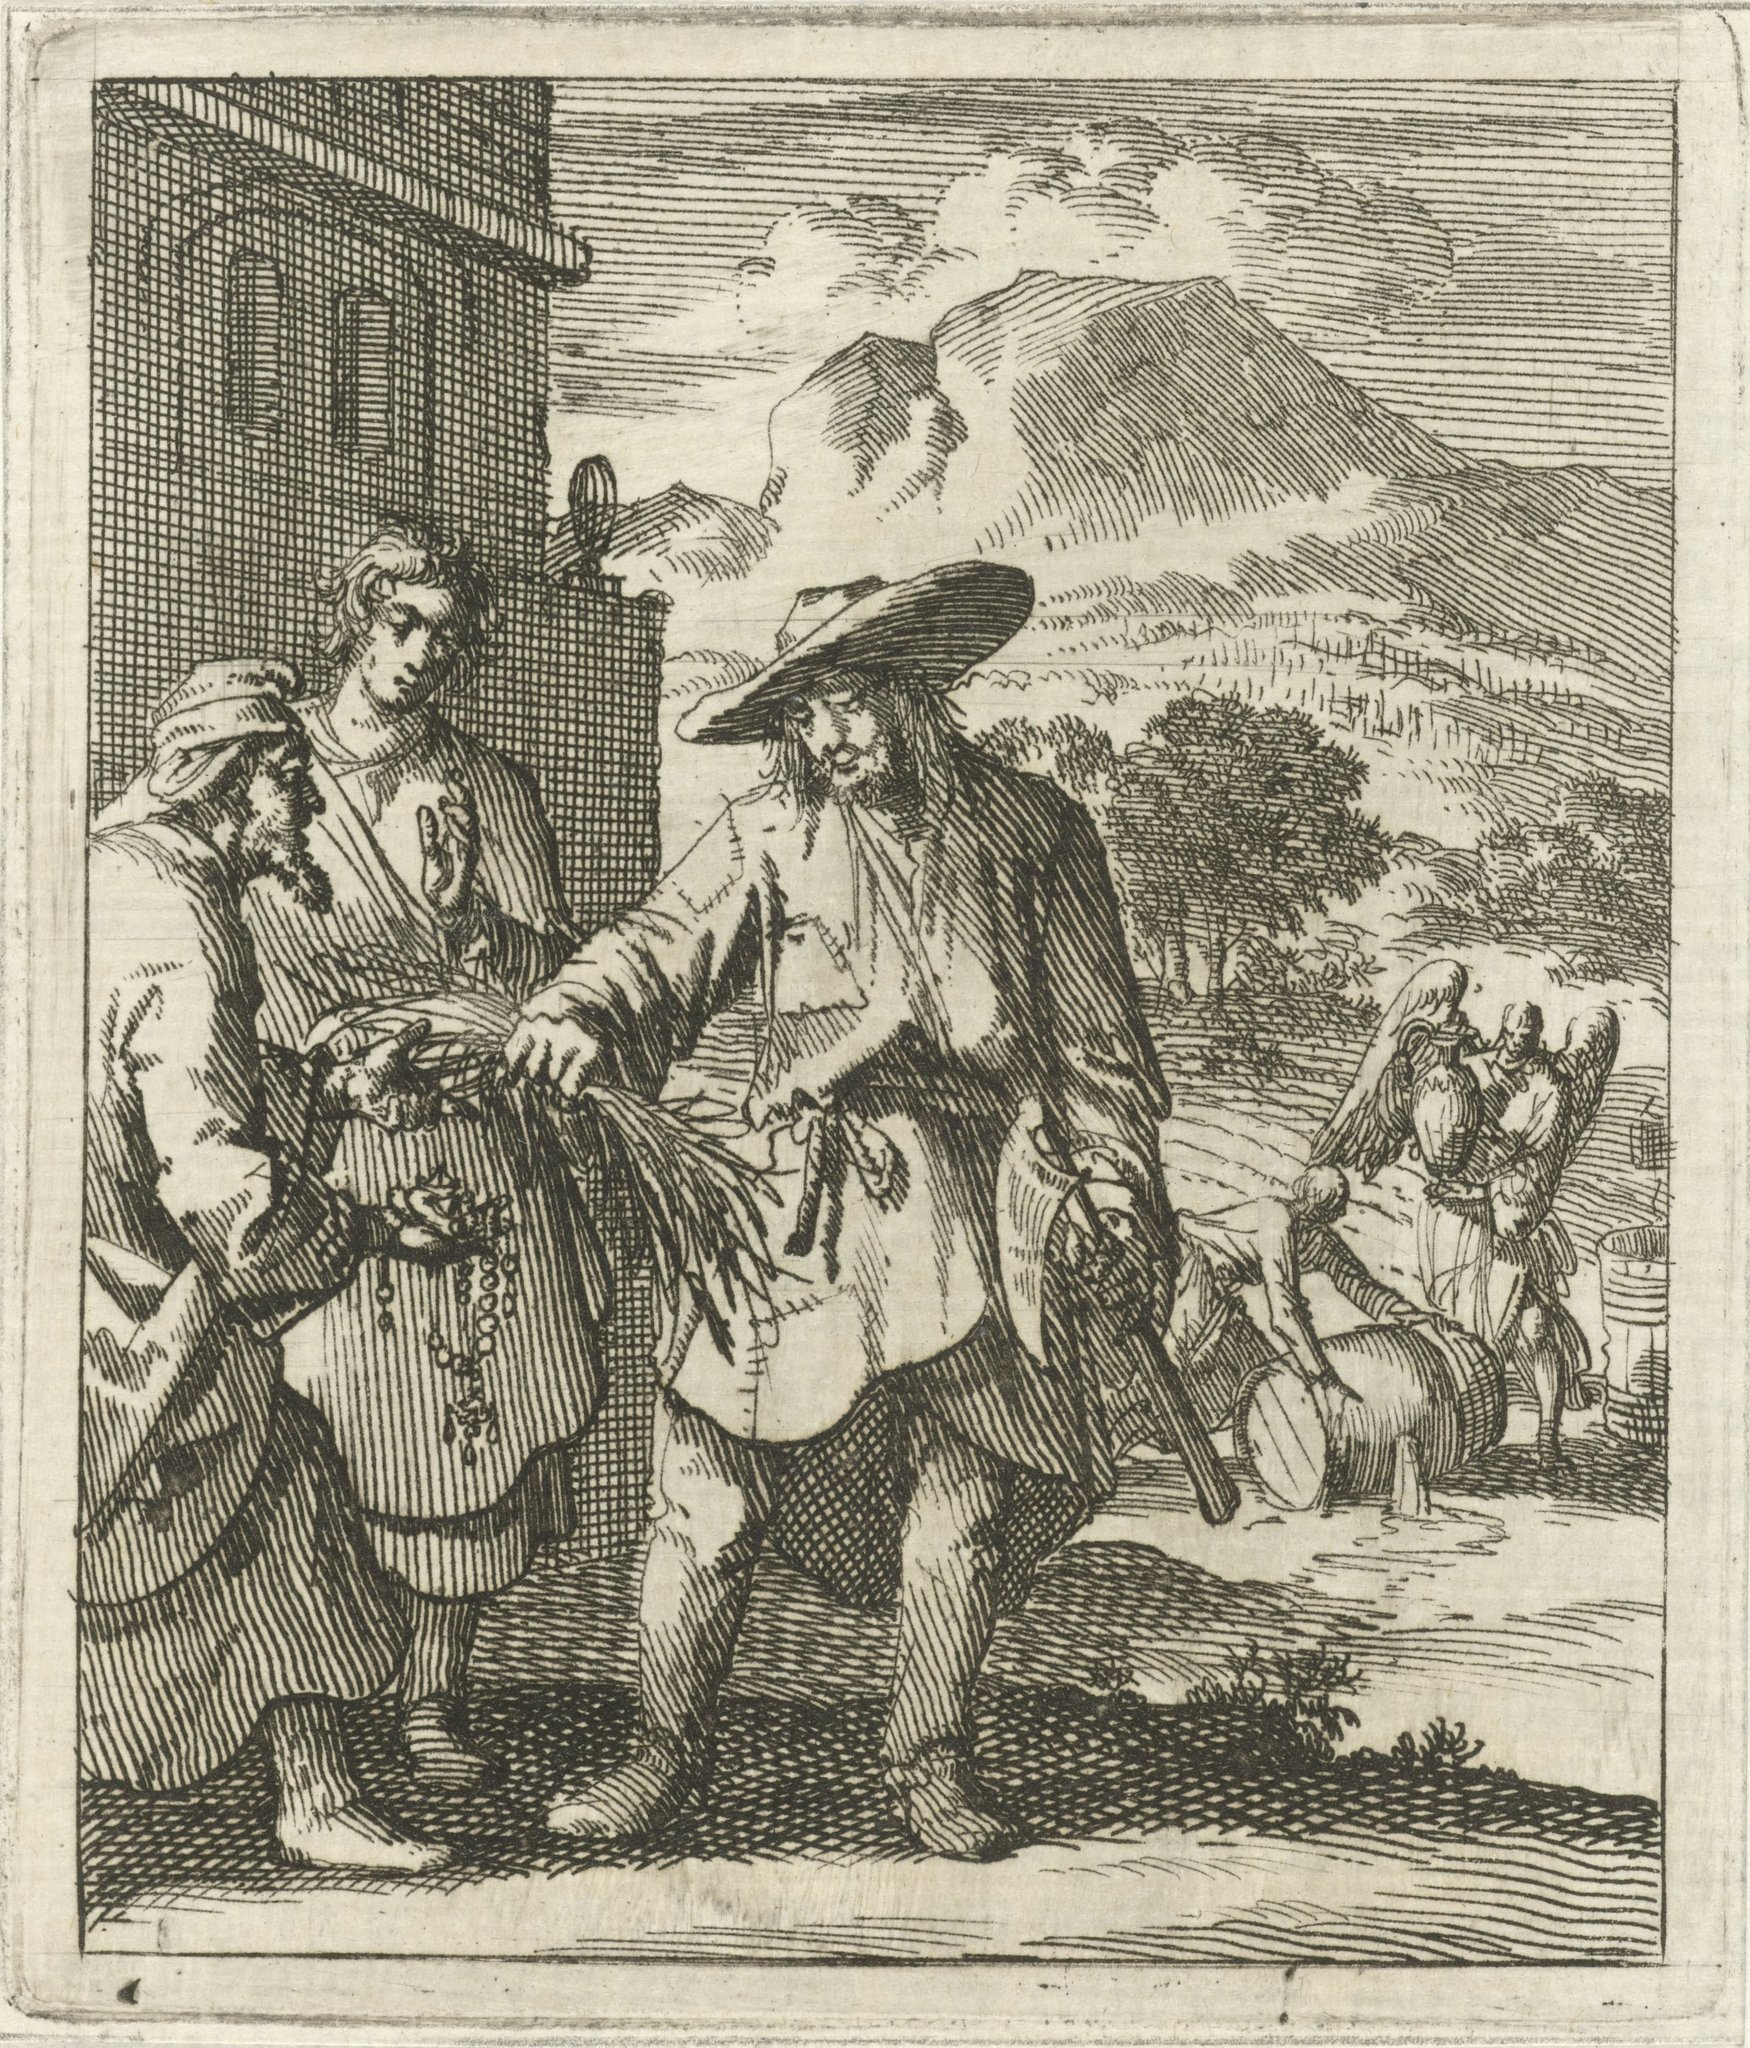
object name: print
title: Bejaarde man biedt een boer kostbaarheden aan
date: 1689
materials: paper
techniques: etching, letterpress printing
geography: amsterdam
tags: old man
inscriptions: collector's mark: Lugt 2228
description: Illustratie uit: Huygen, Pieter. De beginselen van Gods koninkryk in den mensch uitgedrukt in zinnebeelden. Amsterdam: wed. Arentsz. Pieter (II), 1689, p. 134.